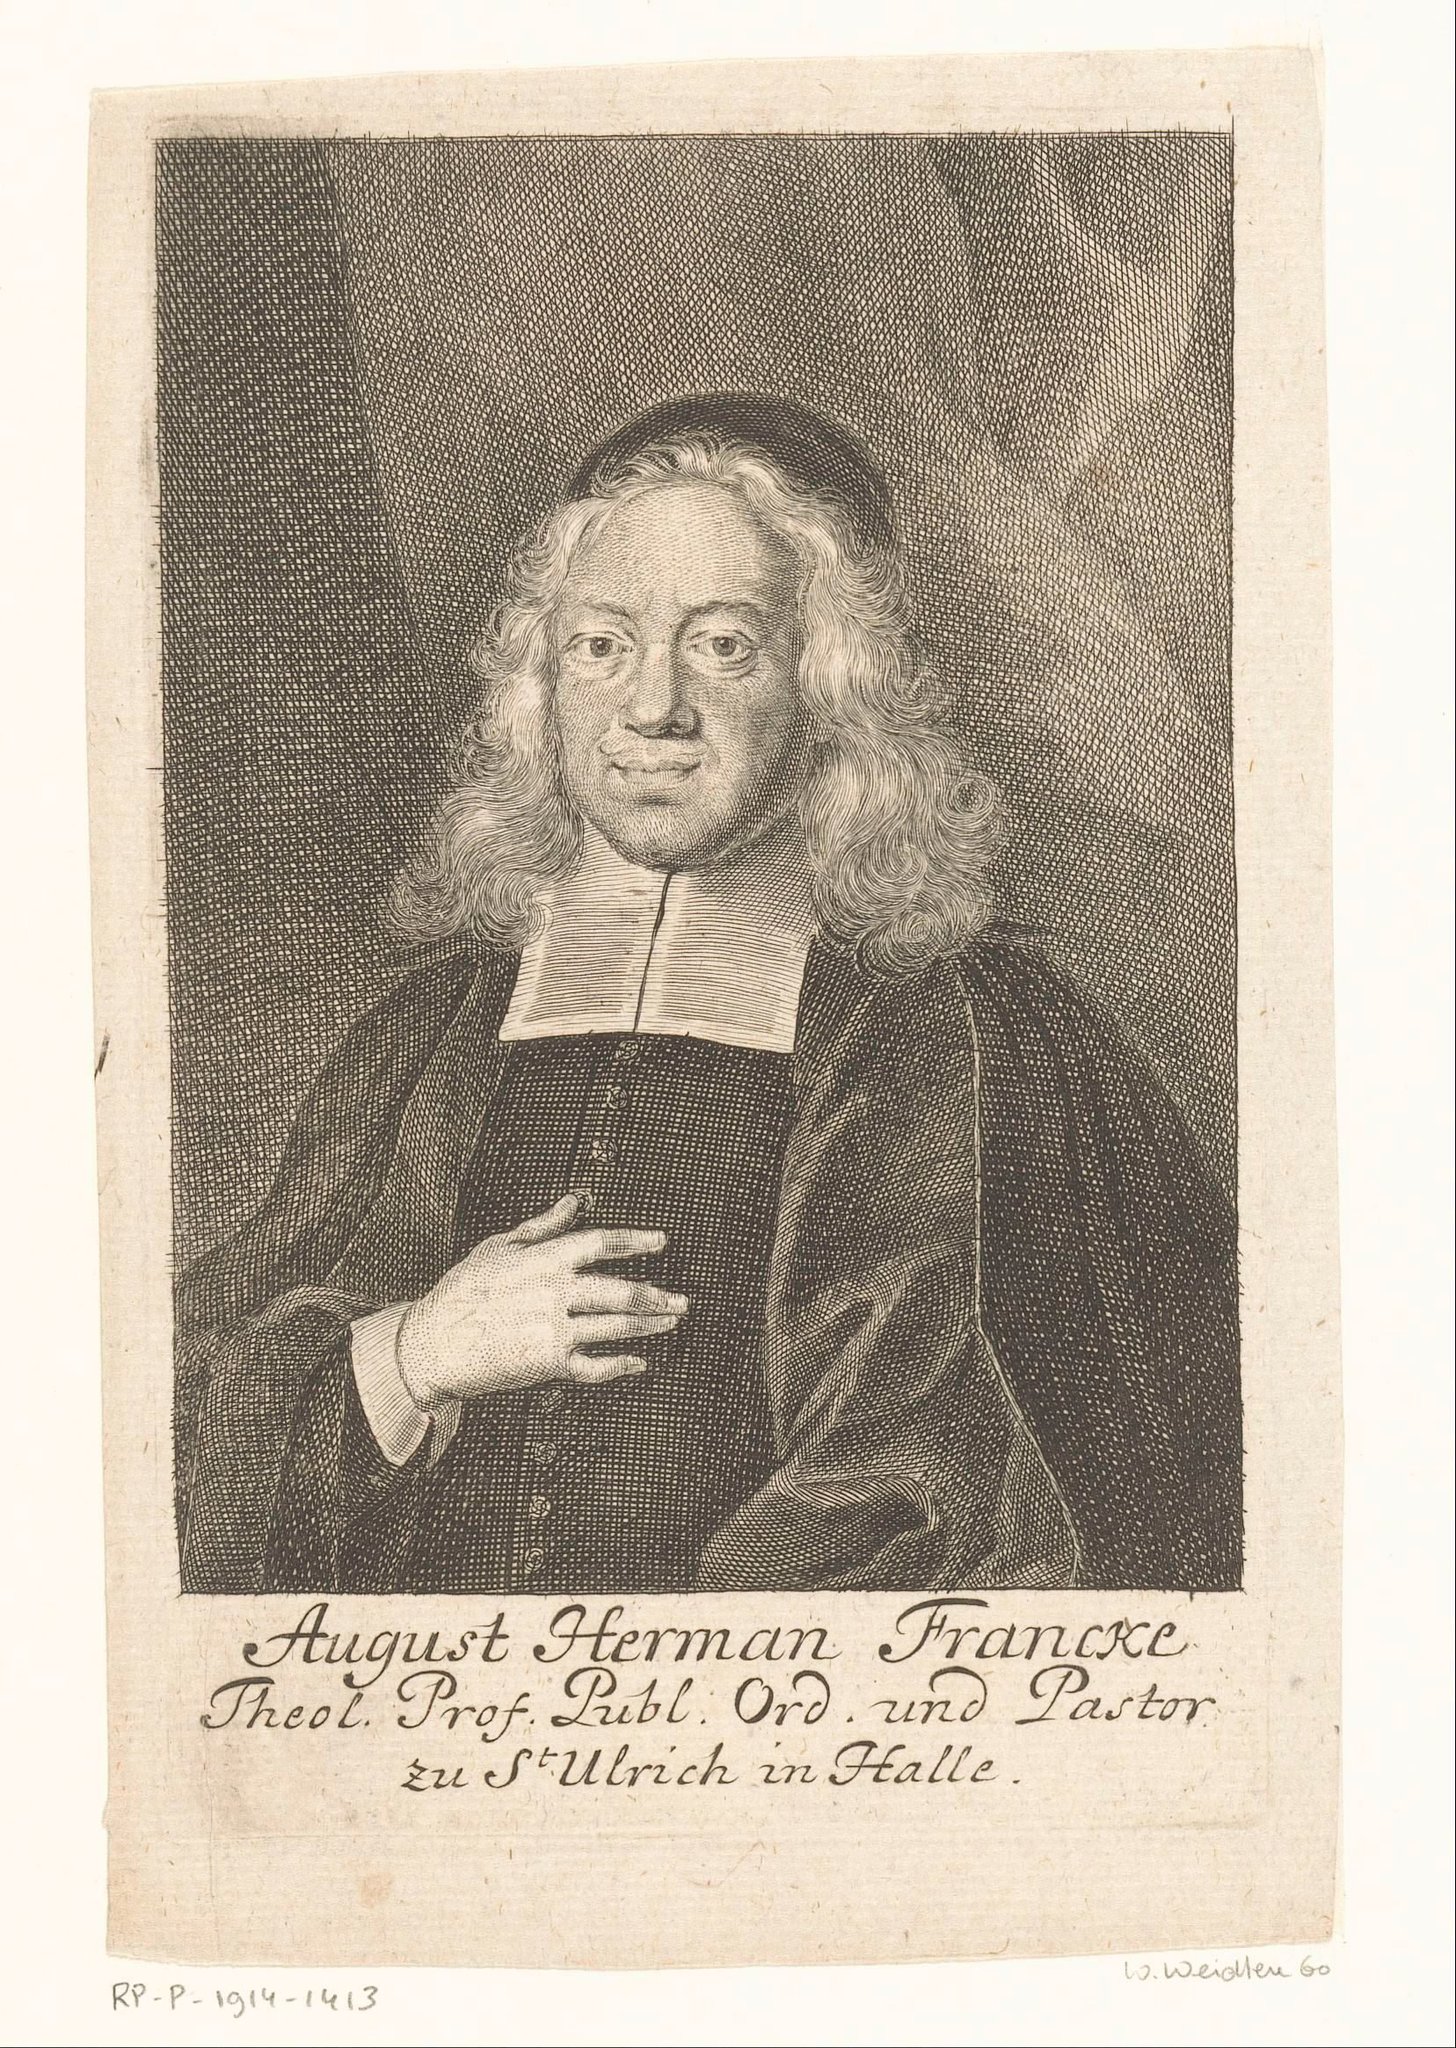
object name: print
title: Portret van August Hermann Francke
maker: martin bernigeroth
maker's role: print maker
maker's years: 1670-1733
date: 1724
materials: paper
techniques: engraving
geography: leipzig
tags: historical persons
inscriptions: collector's mark: Lugt 2228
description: Prent ook gebruikt in: Deutsche Acta Eruditorum (...). dl. 99. Leipzig: Johann Gottlieb Gleditsch, 1724.